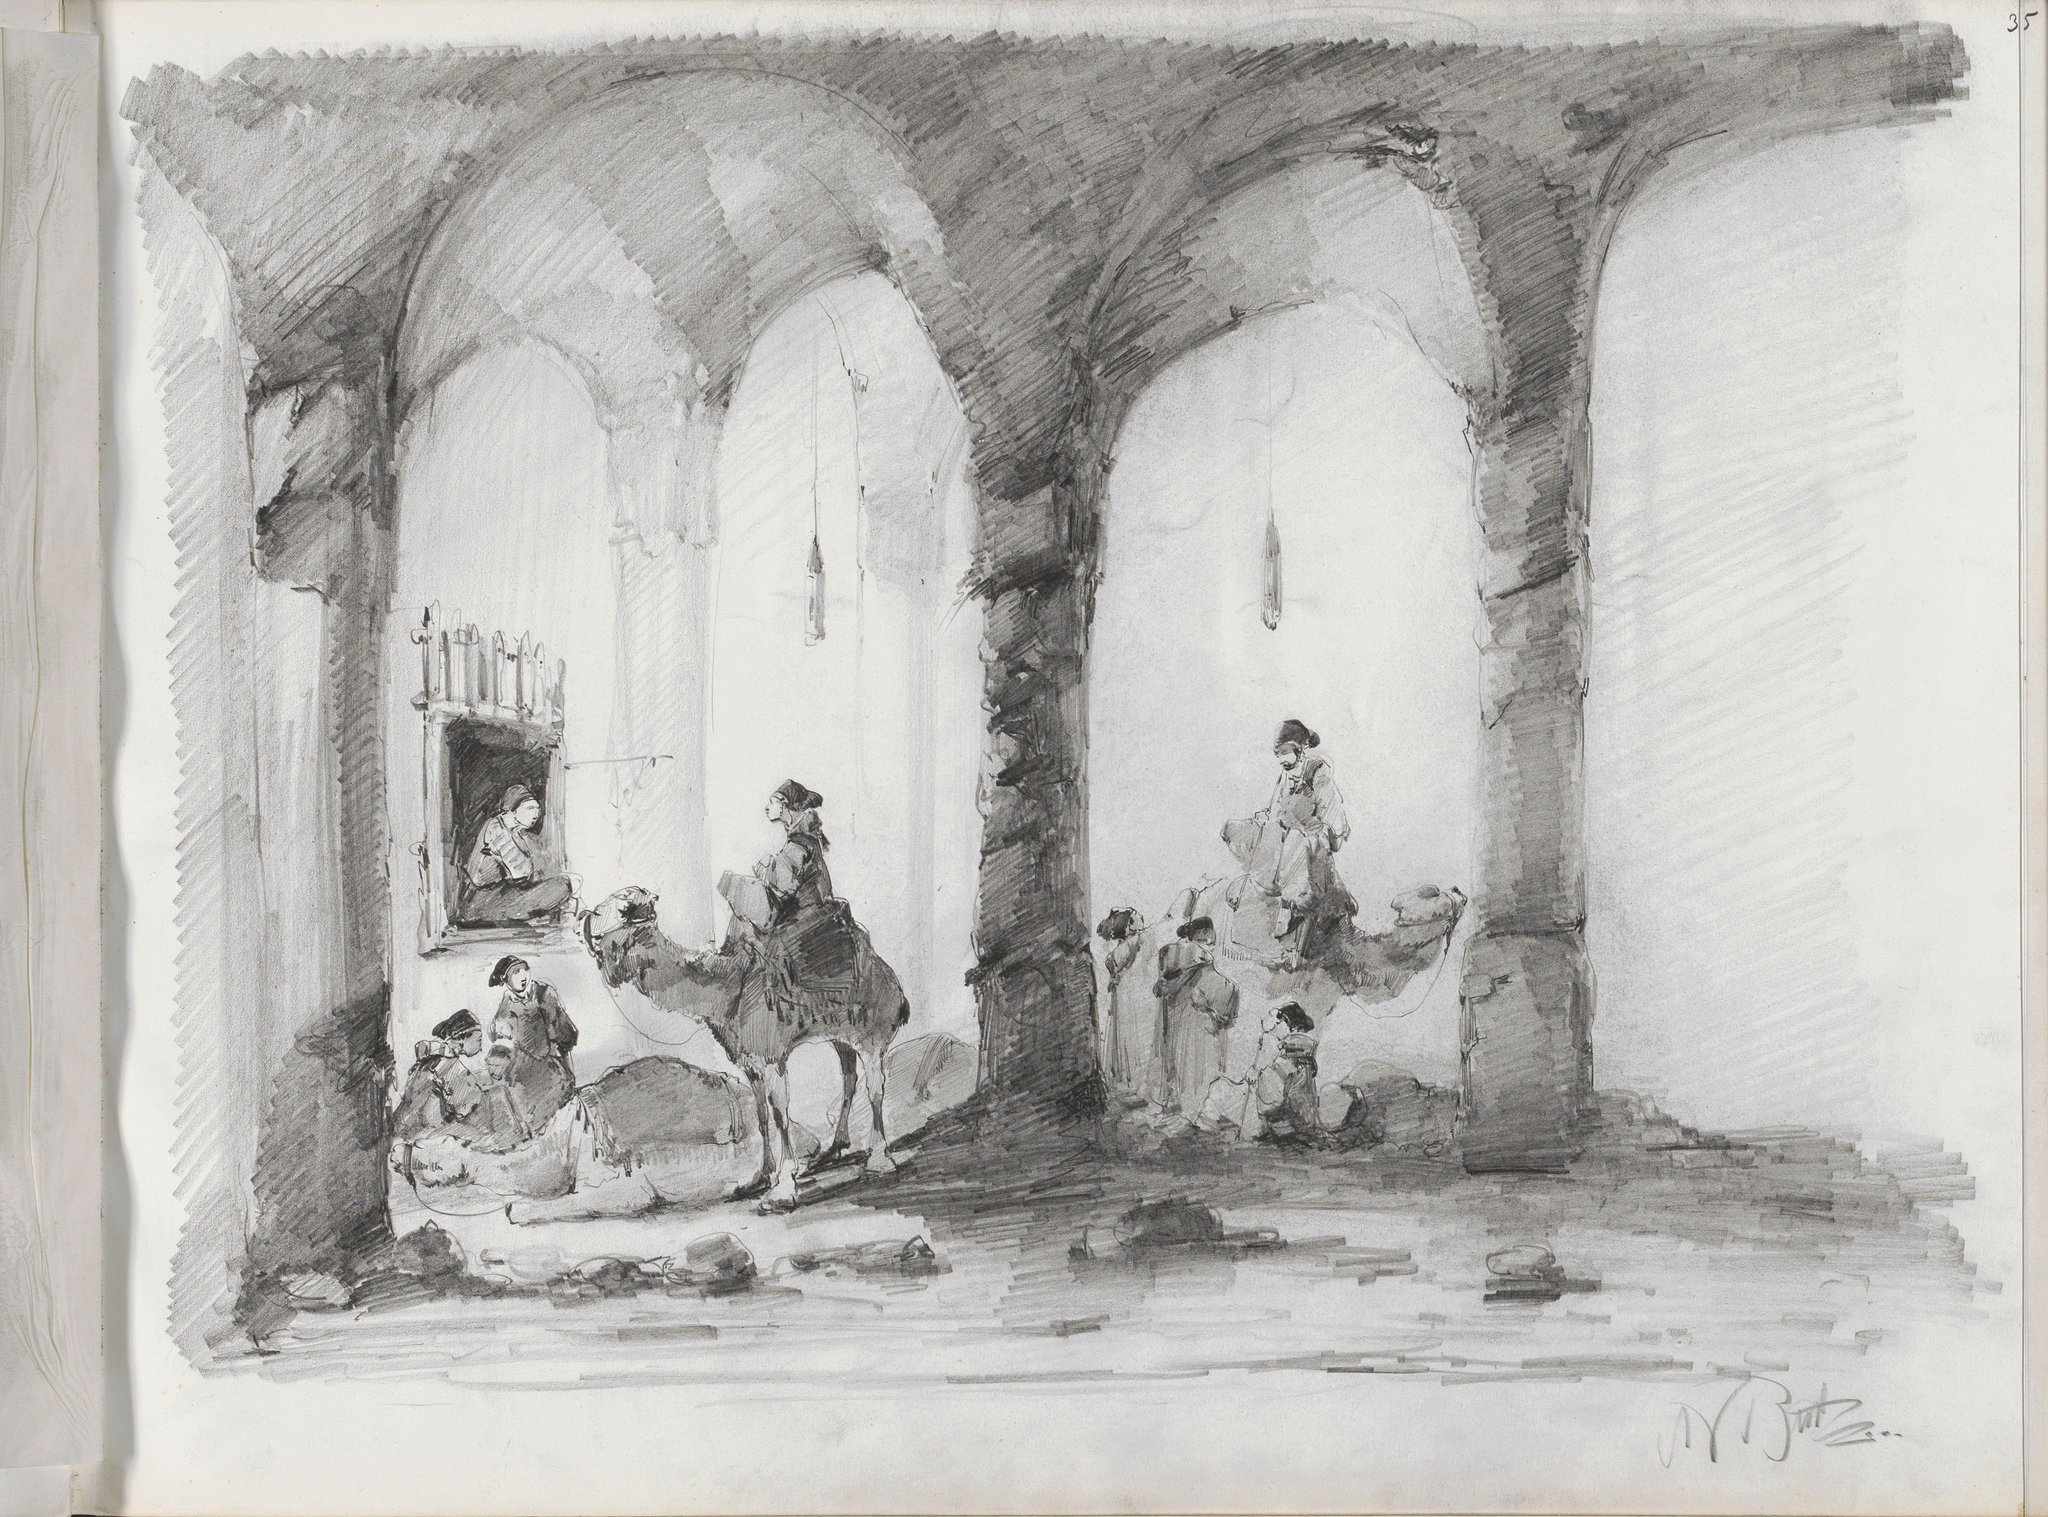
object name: sketchbook leaf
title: Figuren en kamelen op een overkapte binnenplaats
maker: albertus van beest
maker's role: draughtsman, print maker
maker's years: 1820-1860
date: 1830-1860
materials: paper, pencil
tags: hoofed animals: camel, folk costume, regional costume, arcade ~ architecture, street (+ city(-scape) with figures, staffage)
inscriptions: signature: ‘A V Beest’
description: Figuren in oosterse kleding staan en zitten op de grond. Twee mannen zitten op een kameel. De ruimte waarin de figuren zich bevinden (mogelijk een galerij of binnenplaats bij een straat) is overkapt met een boogconstructie. Blad 35 recto uit een schetsboek met 46 bladen.